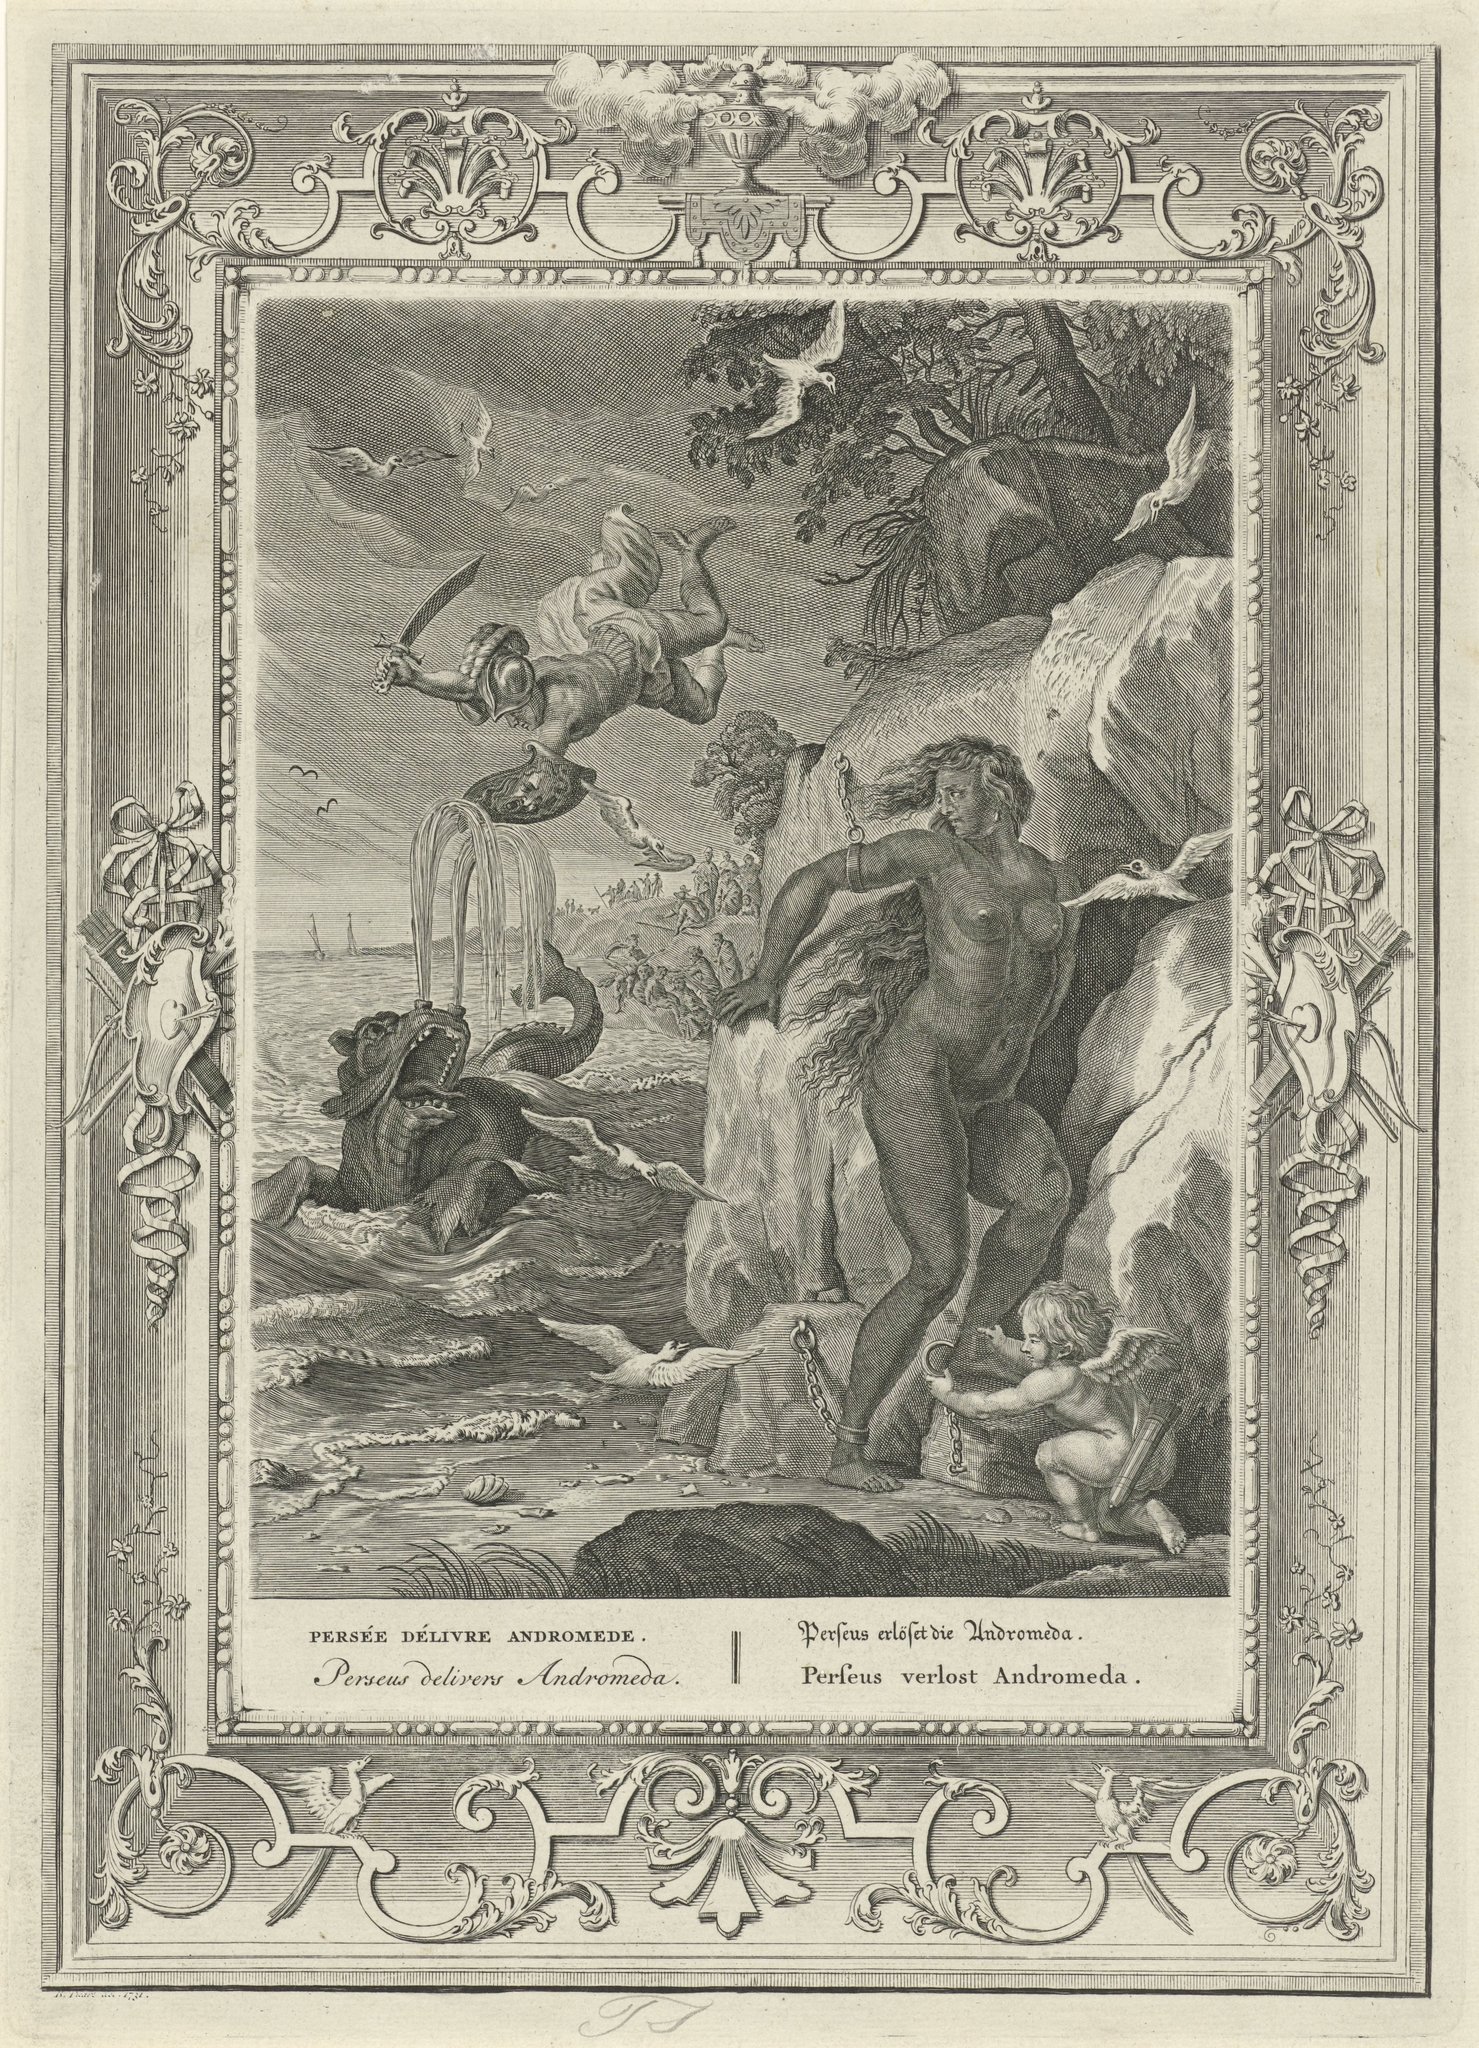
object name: print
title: Perseus en Andromeda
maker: bernard picart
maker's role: draughtsman, print maker, publisher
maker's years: 1673-1733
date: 1731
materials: paper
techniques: engraving, etching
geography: amsterdam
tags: scrollwork, strapwork ~ ornament, perseus frees andromeda of her chains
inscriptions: collector's mark: Lugt 2228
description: Andromeda, de dochter van een Ethiopische koning, is vastgeketend aan een rots bij de zee, als offer aan een zeemonster. Perseus werd verliefd op haar en doodt het monster. Amor verlost haar van de ketens. In de marge de titel in het Frans, Engels, Duits en Nederlands. De voorstelling is gedecoreerd met een ornamentele rand.